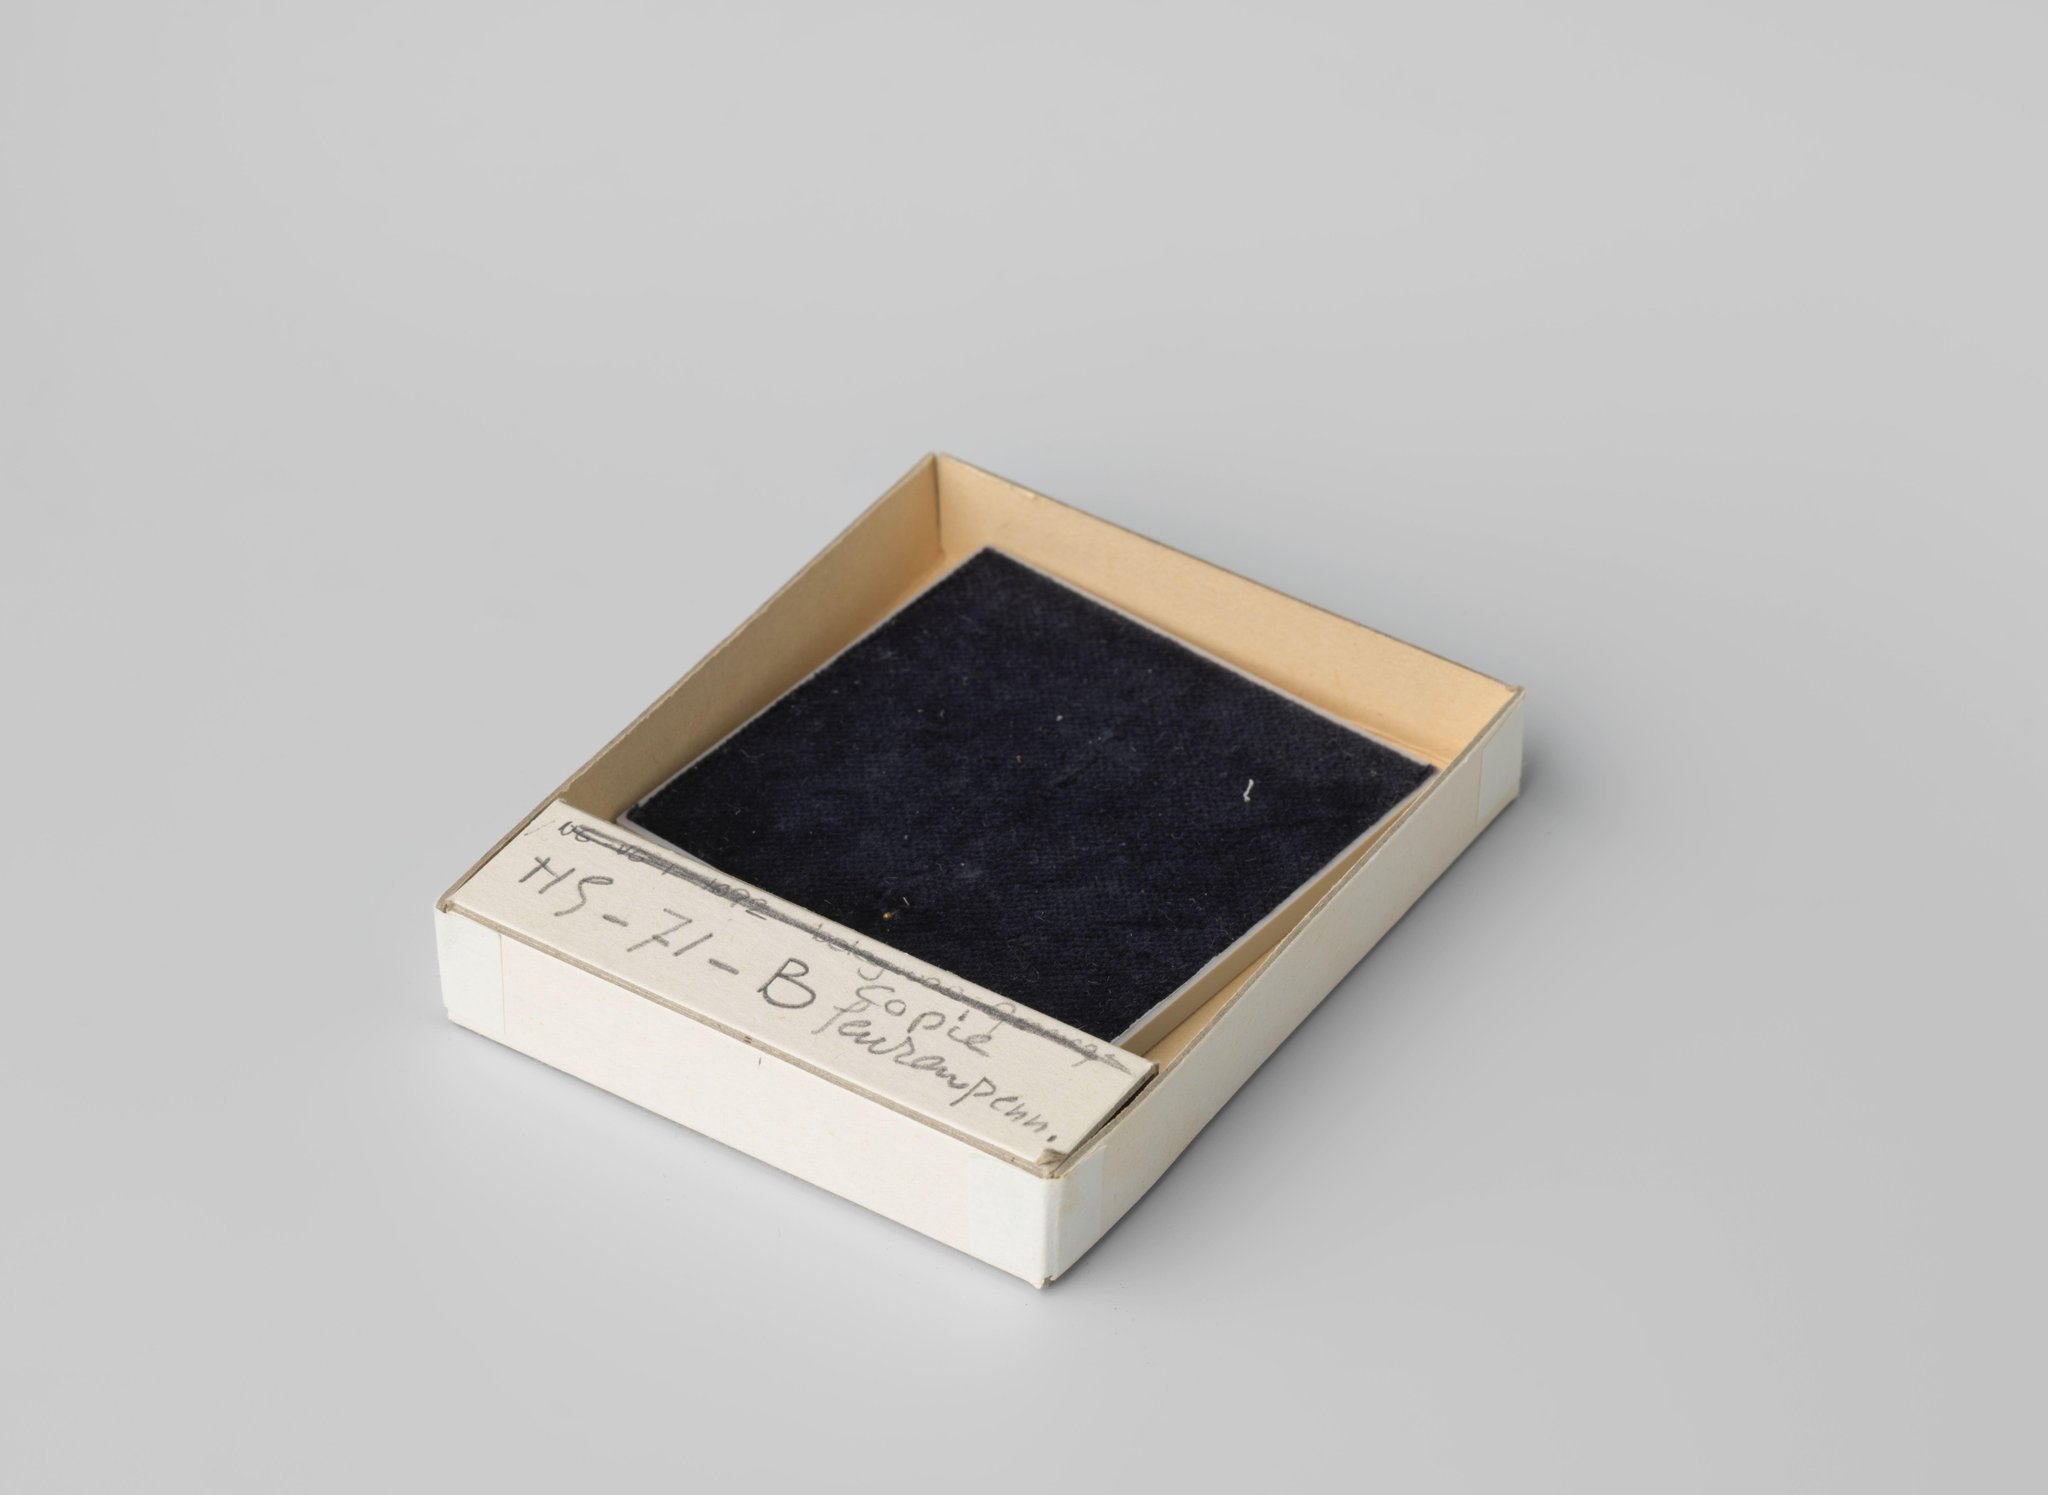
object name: box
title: Doos van een geuzenpenning met napje en kalebasjes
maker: Anonymous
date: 1800-1900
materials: cardboard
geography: low countries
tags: philip ii of spain, spain